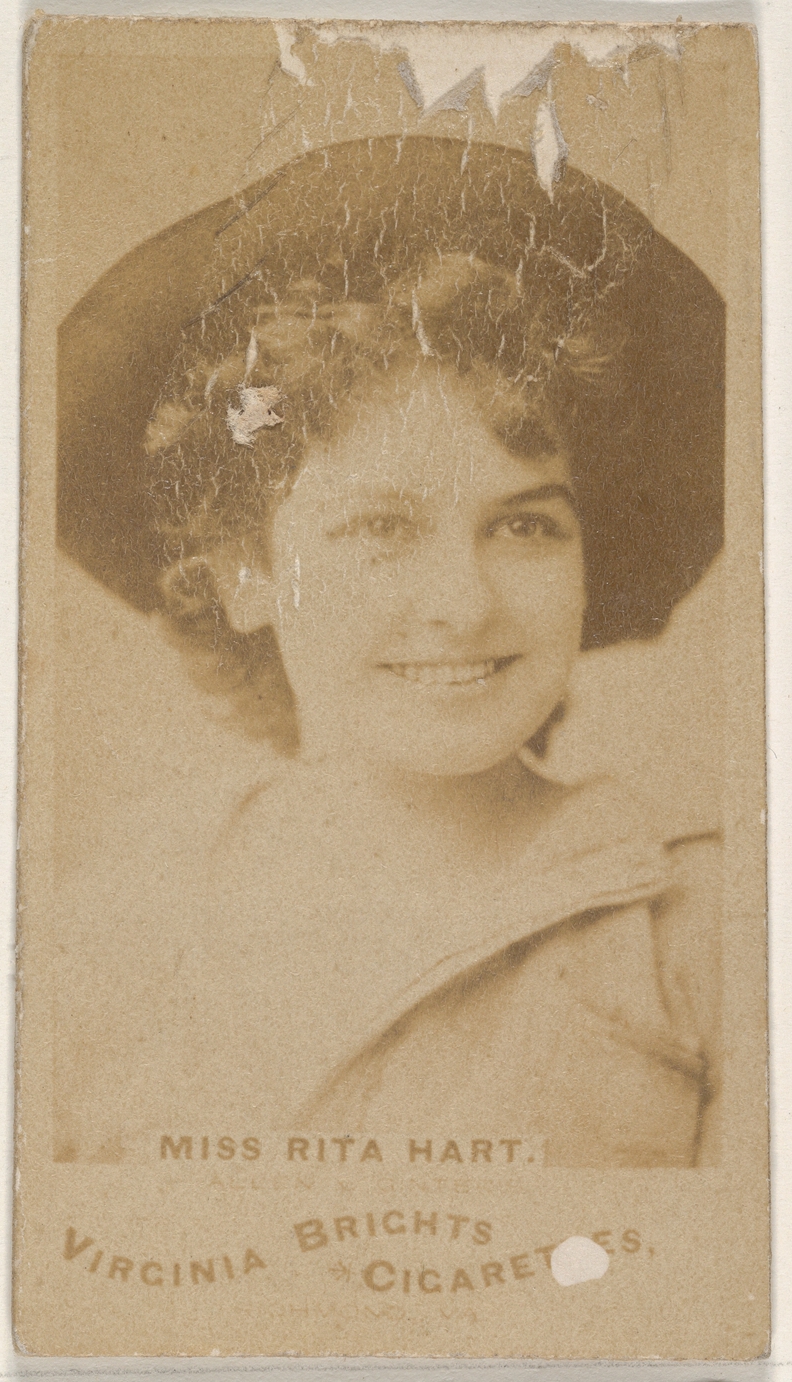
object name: photograph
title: Miss Rita Hart, from the Actors and Actresses series (N45, Type 1) for Virginia Brights Cigarettes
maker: allen & ginter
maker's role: publisher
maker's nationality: american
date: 1888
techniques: albumen silver print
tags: portraits,women,actresses